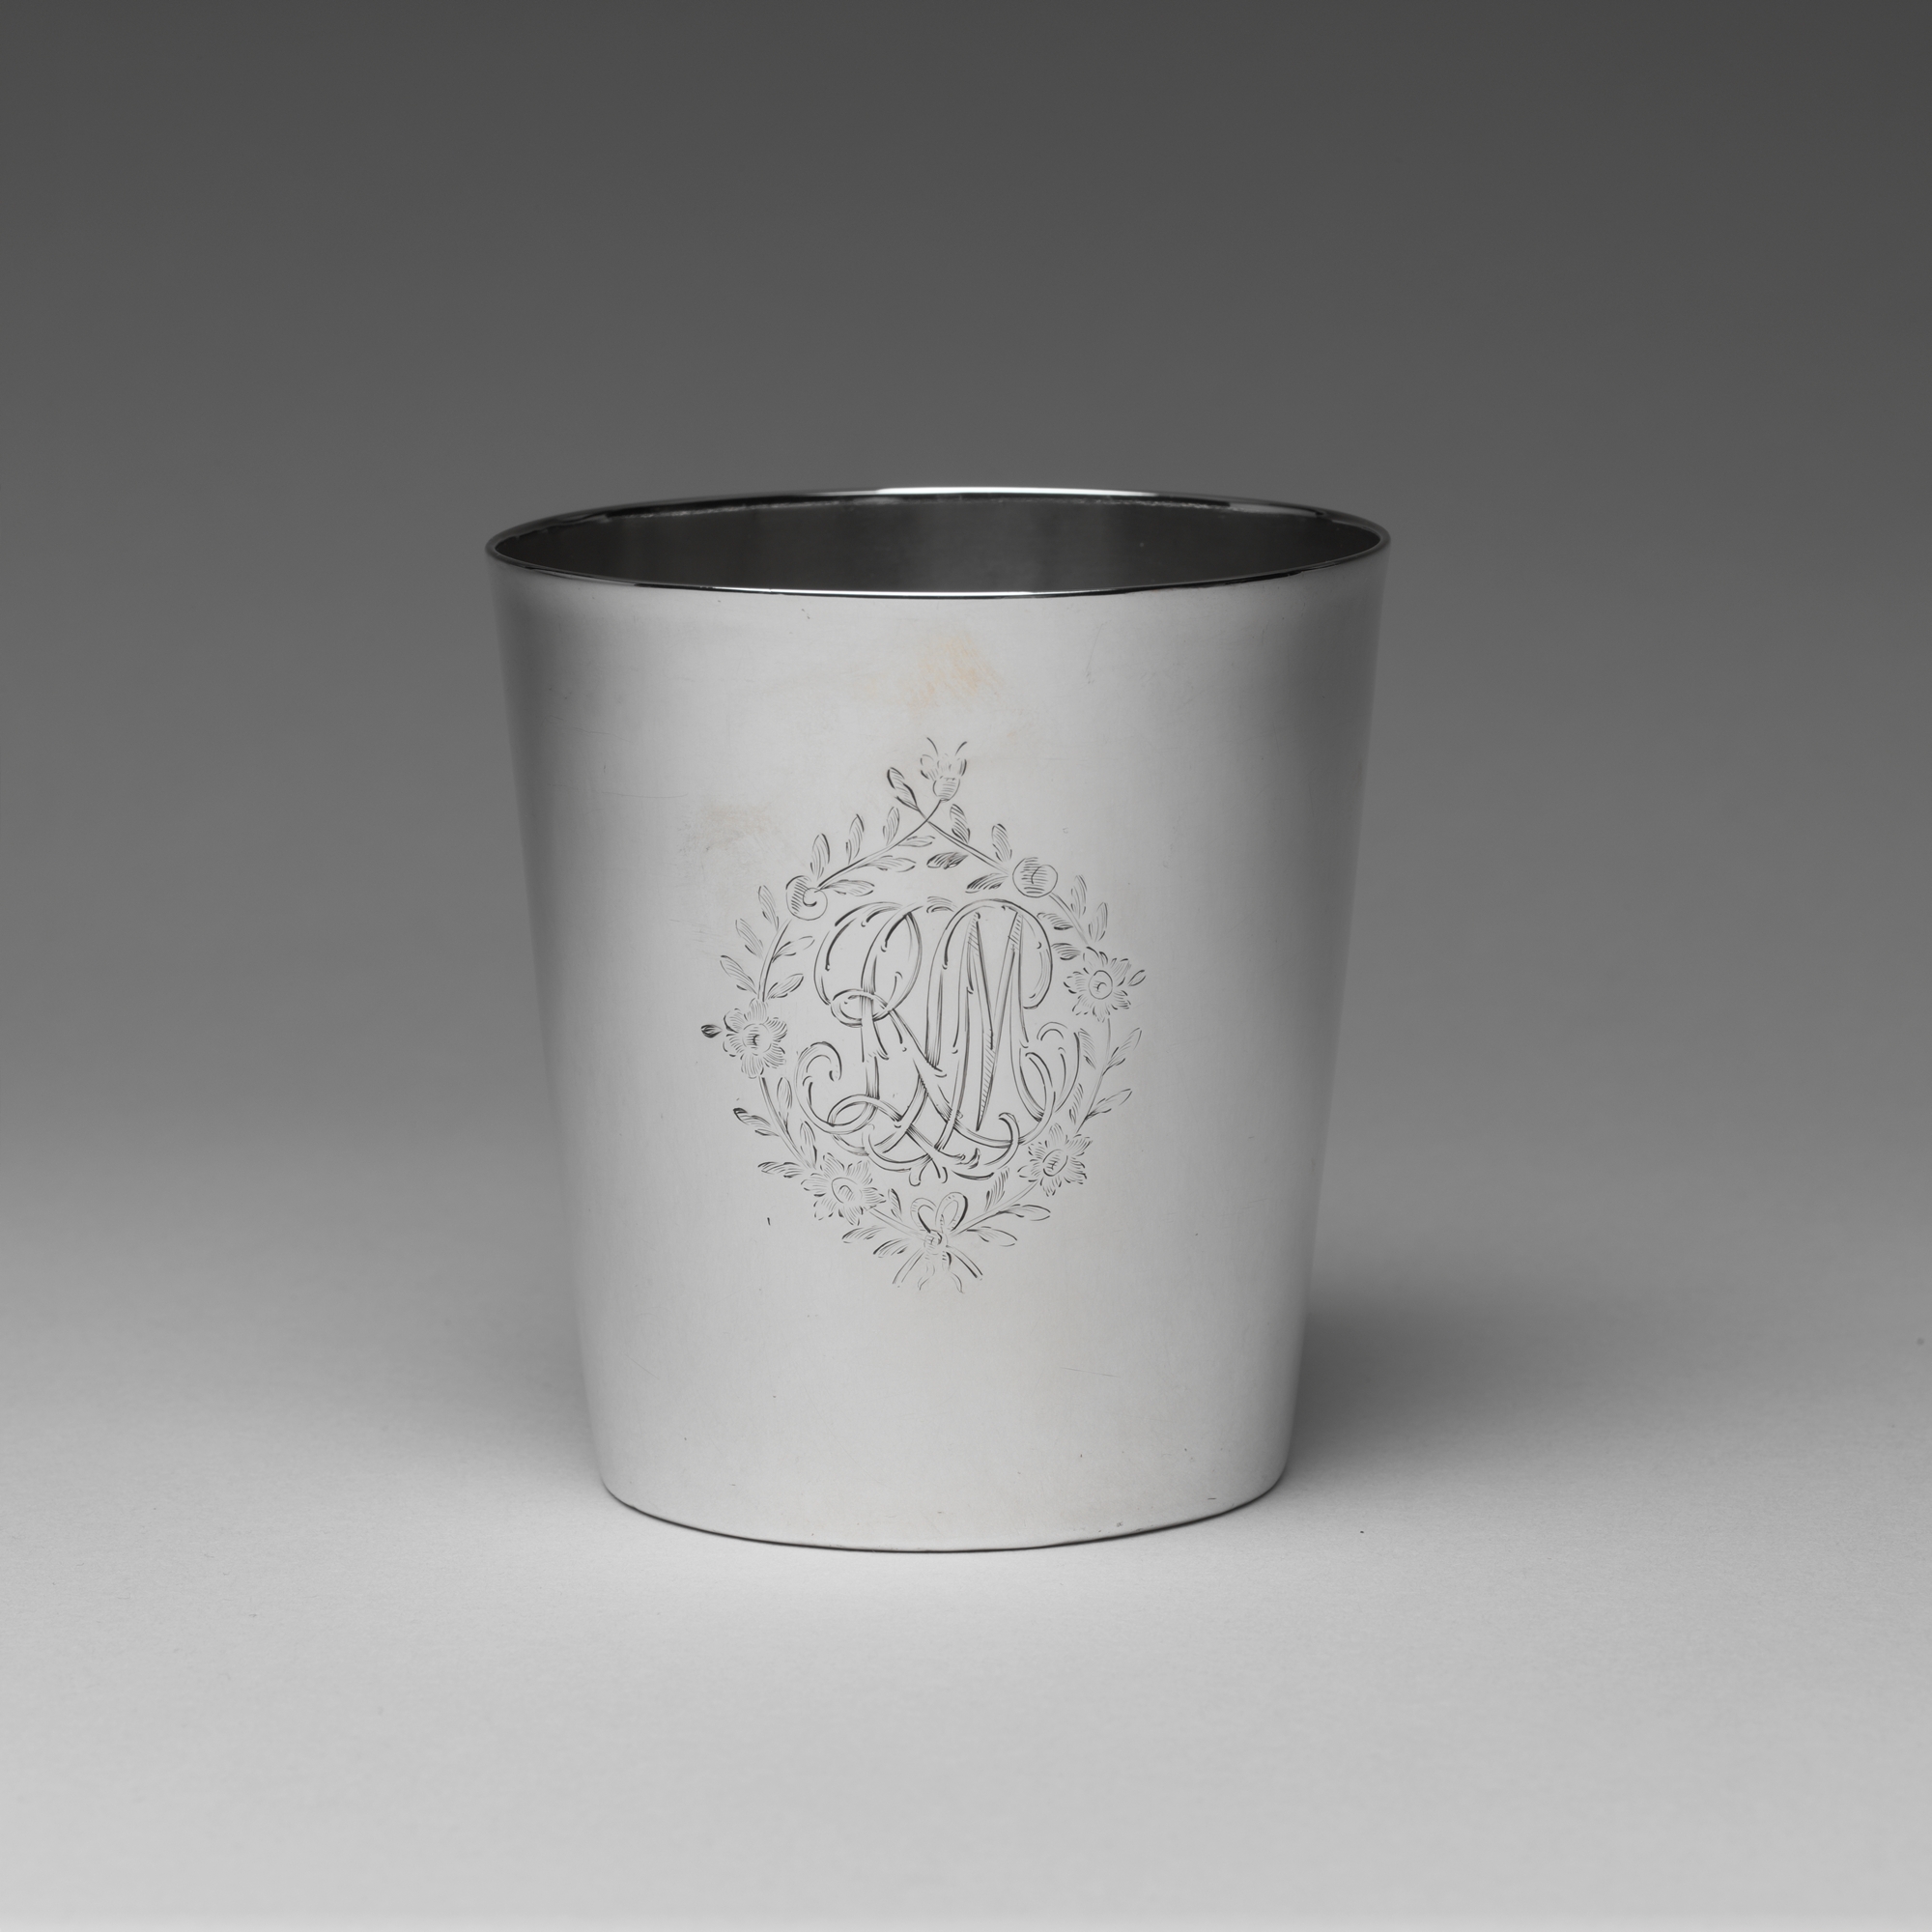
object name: beaker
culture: american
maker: cary dunn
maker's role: maker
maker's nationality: american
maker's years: 1762-1796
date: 1770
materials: silver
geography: united states